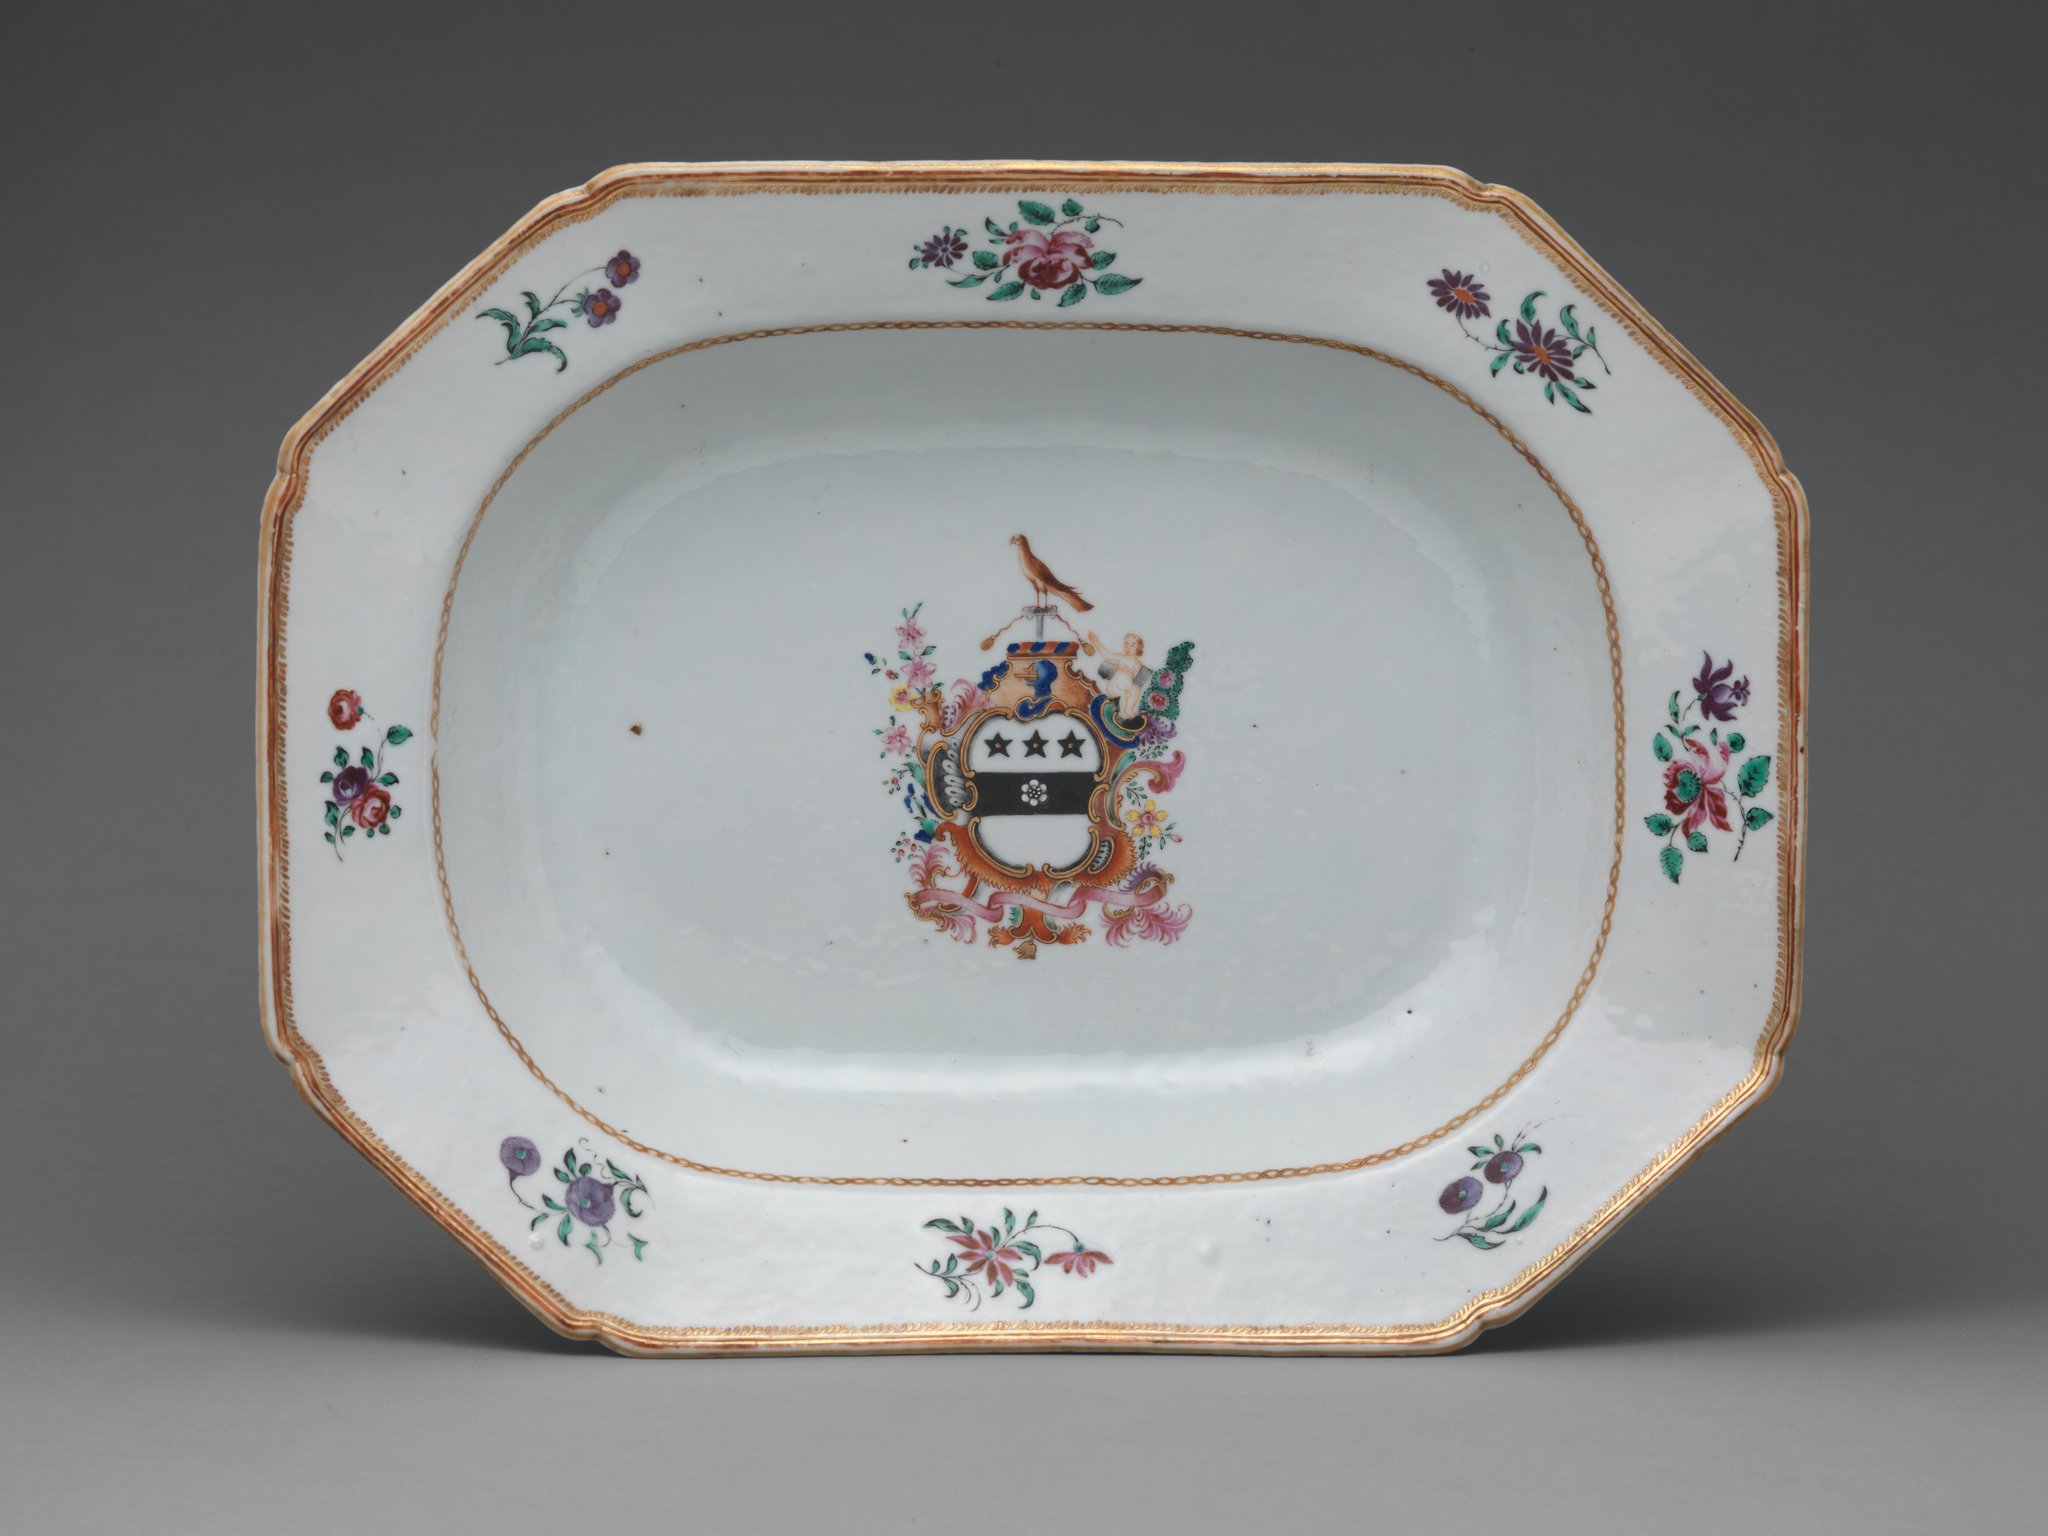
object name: platter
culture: chinese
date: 1785-1790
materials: porcelain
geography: china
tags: birds,flowers,coat of arms